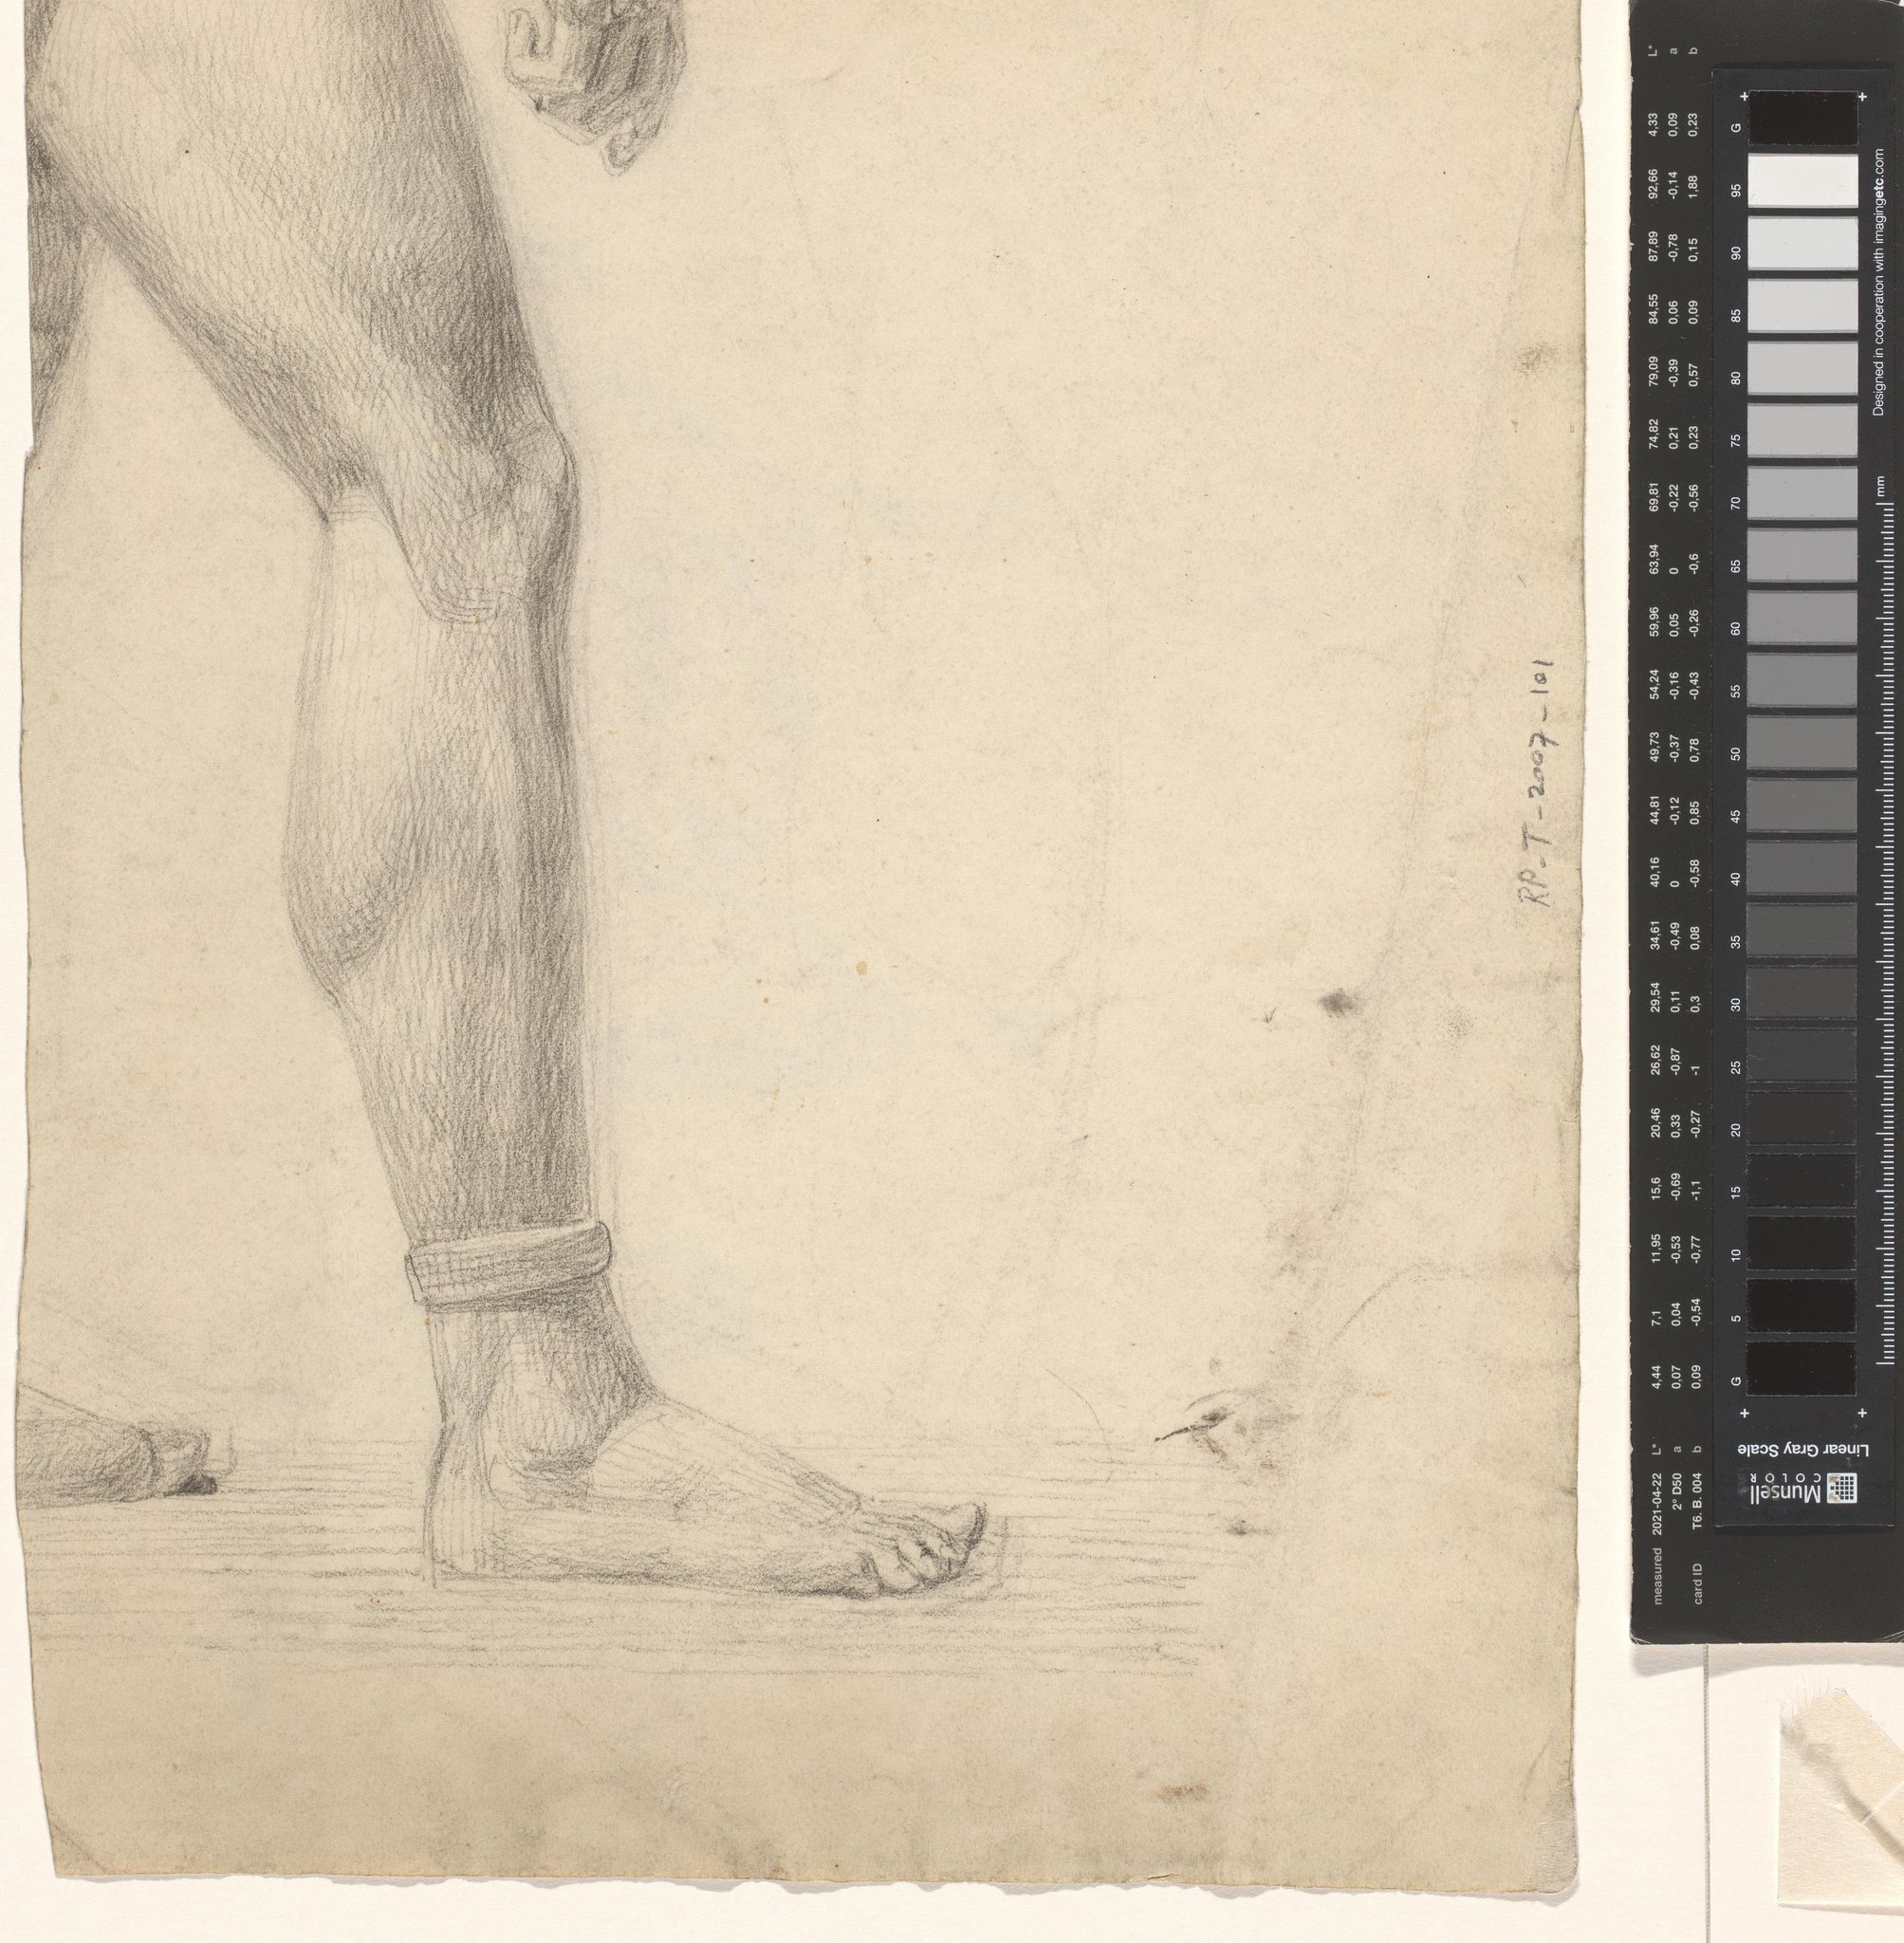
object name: drawing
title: Studie van een hoofd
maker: karel van mander (i)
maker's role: draughtsman, painter, print maker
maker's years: 1548-1606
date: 1592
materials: ink, paper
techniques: brush, pen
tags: head (human)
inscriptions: date